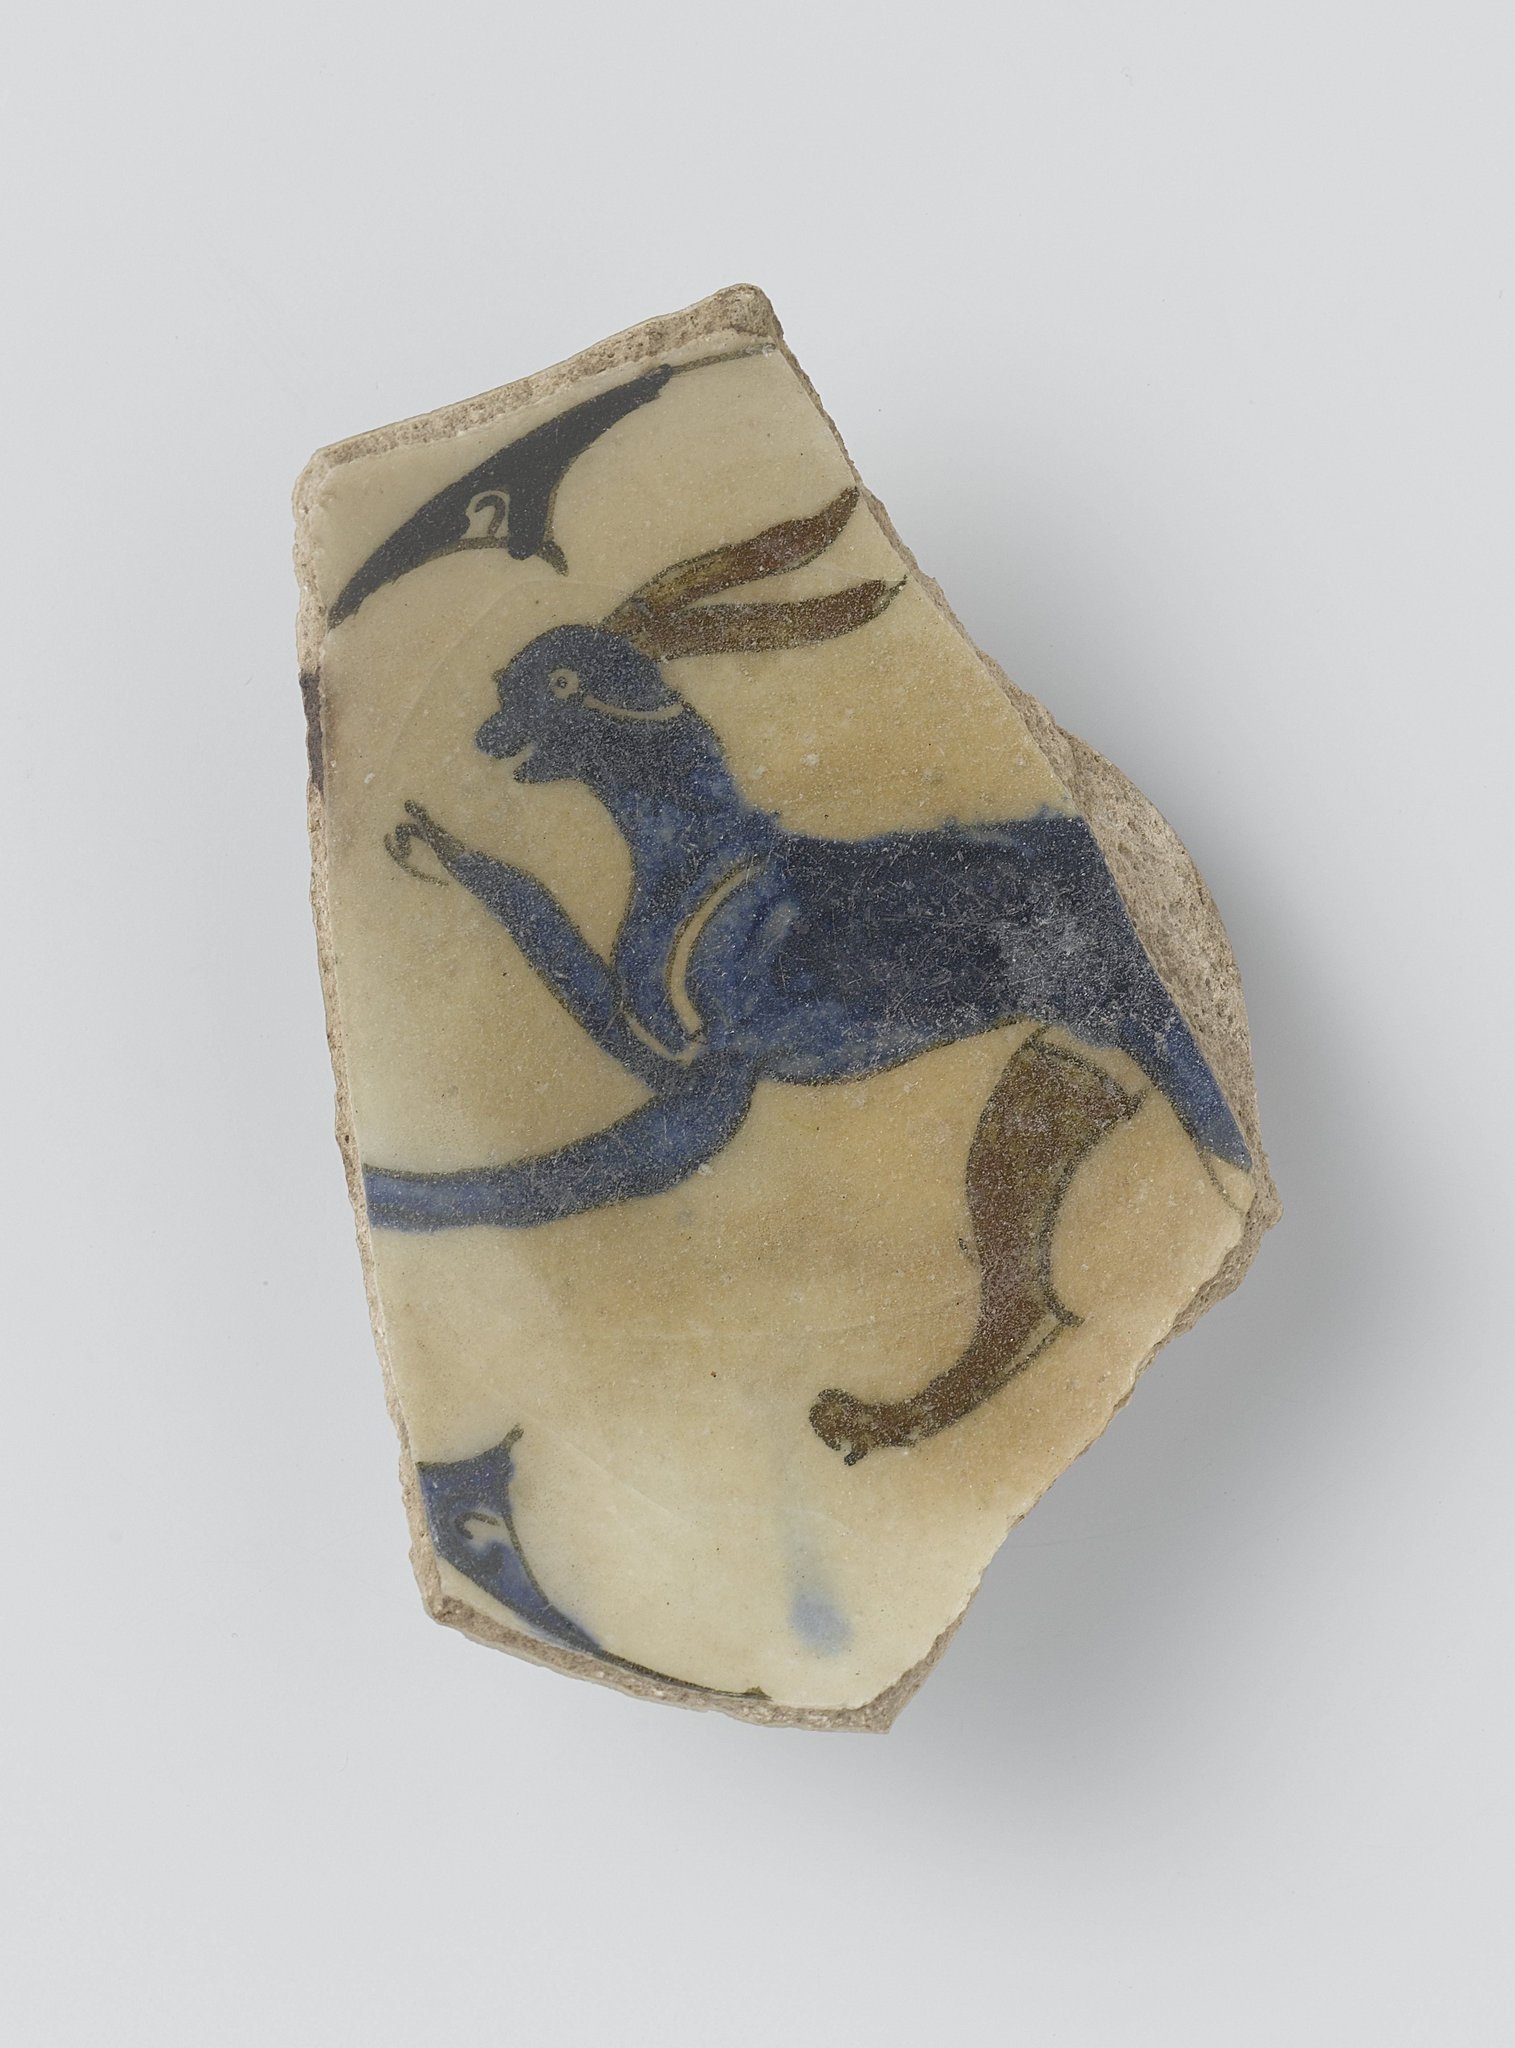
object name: fragment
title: Fragment of a small container with a hare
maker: Anonymous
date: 1200-1299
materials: glaze, earthenware, paint, quartz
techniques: firing, turning, vitrification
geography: syria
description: Fragment van de bodem van een kleine bak van kwarts-fritgoed. In het midden een haas in blauw en bruin binnen een gekartelde omlijsting. Grijsgele aarde. De voet ongeglazuurd. Het fragment is gevonden te Cairo.